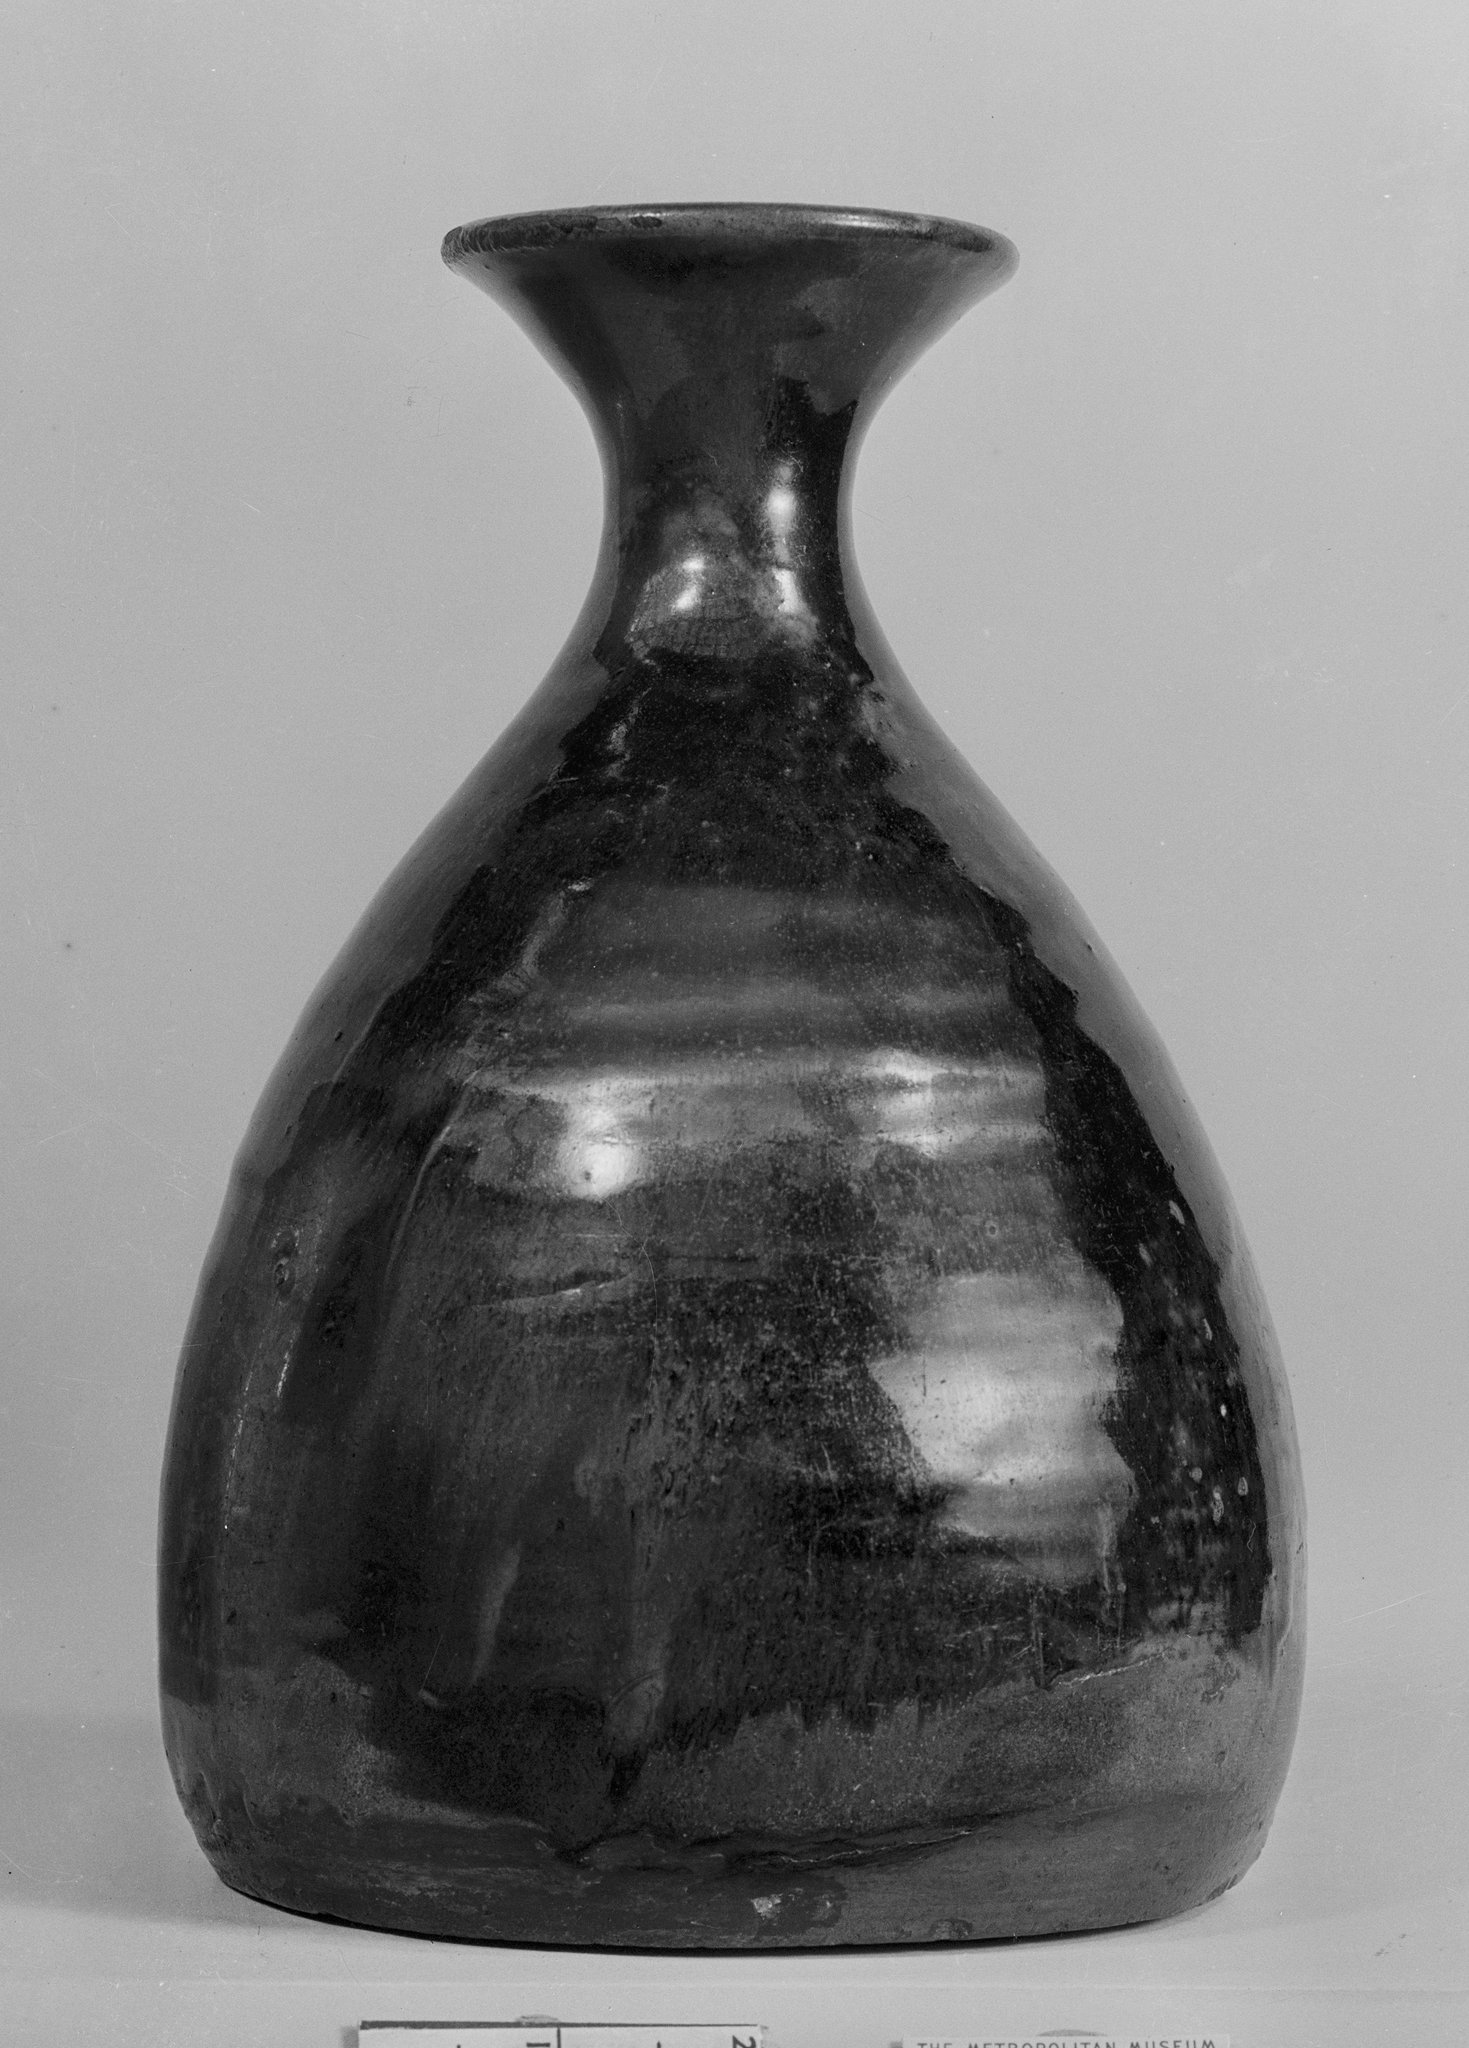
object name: bottle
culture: japanese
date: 1700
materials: clay, glaze